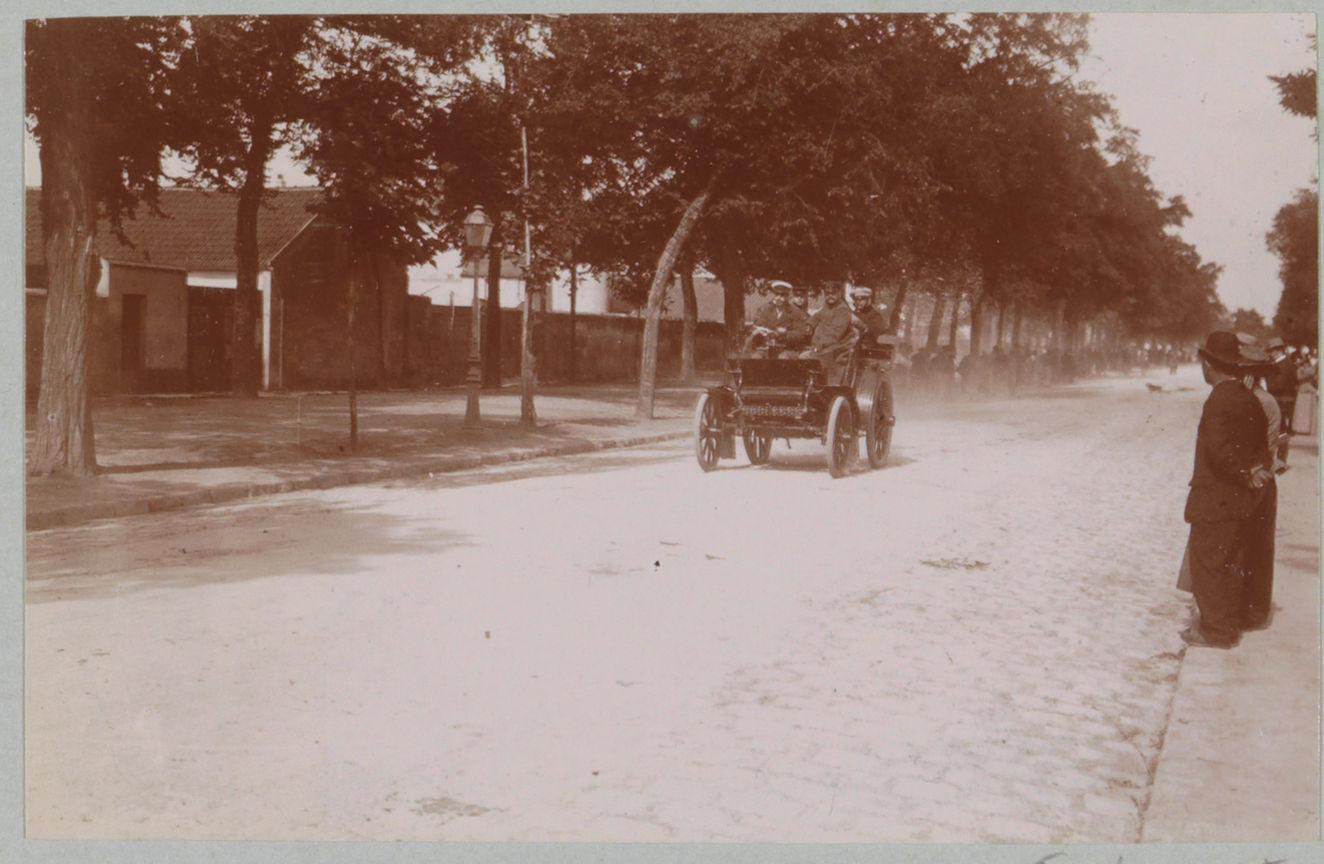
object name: photograph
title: Start van de race Parijs-Amsterdam voor automobielen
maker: delizy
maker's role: manufacturer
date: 1898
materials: paper, photographic support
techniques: gelatin silver print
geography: paris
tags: motorcar racing, automobile, street (+ city(-scape) with figures, staffage), paris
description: Onderdeel van Fotoalbum van een Franse amateurfotograaf met opnames van uitstapjes in Frankrijk, Spanje, België, Luxemburg en Nederland, de eerste automobielen en autoraces.